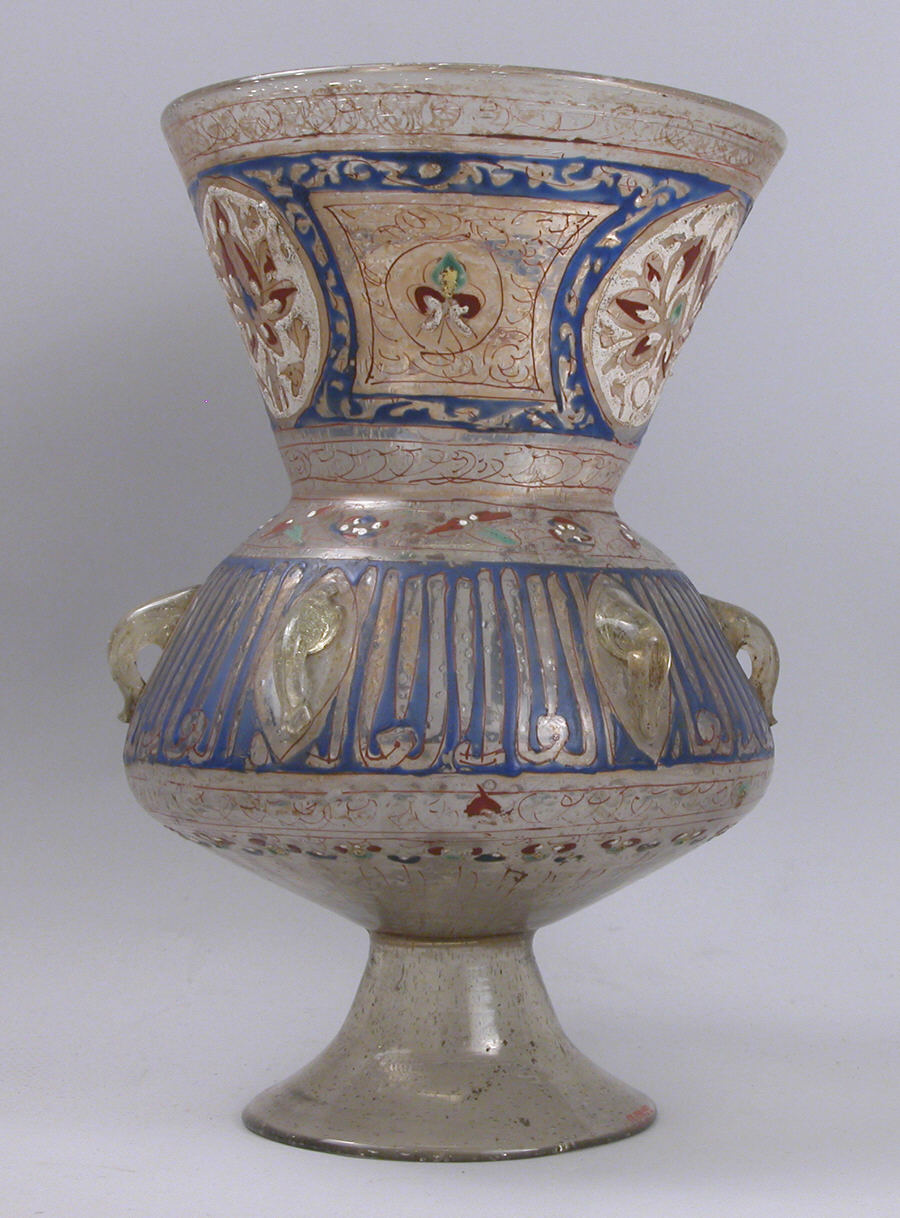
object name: mosque lamp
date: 1301-1400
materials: glass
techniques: enamel, glassblowing, gilding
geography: egypt or syria